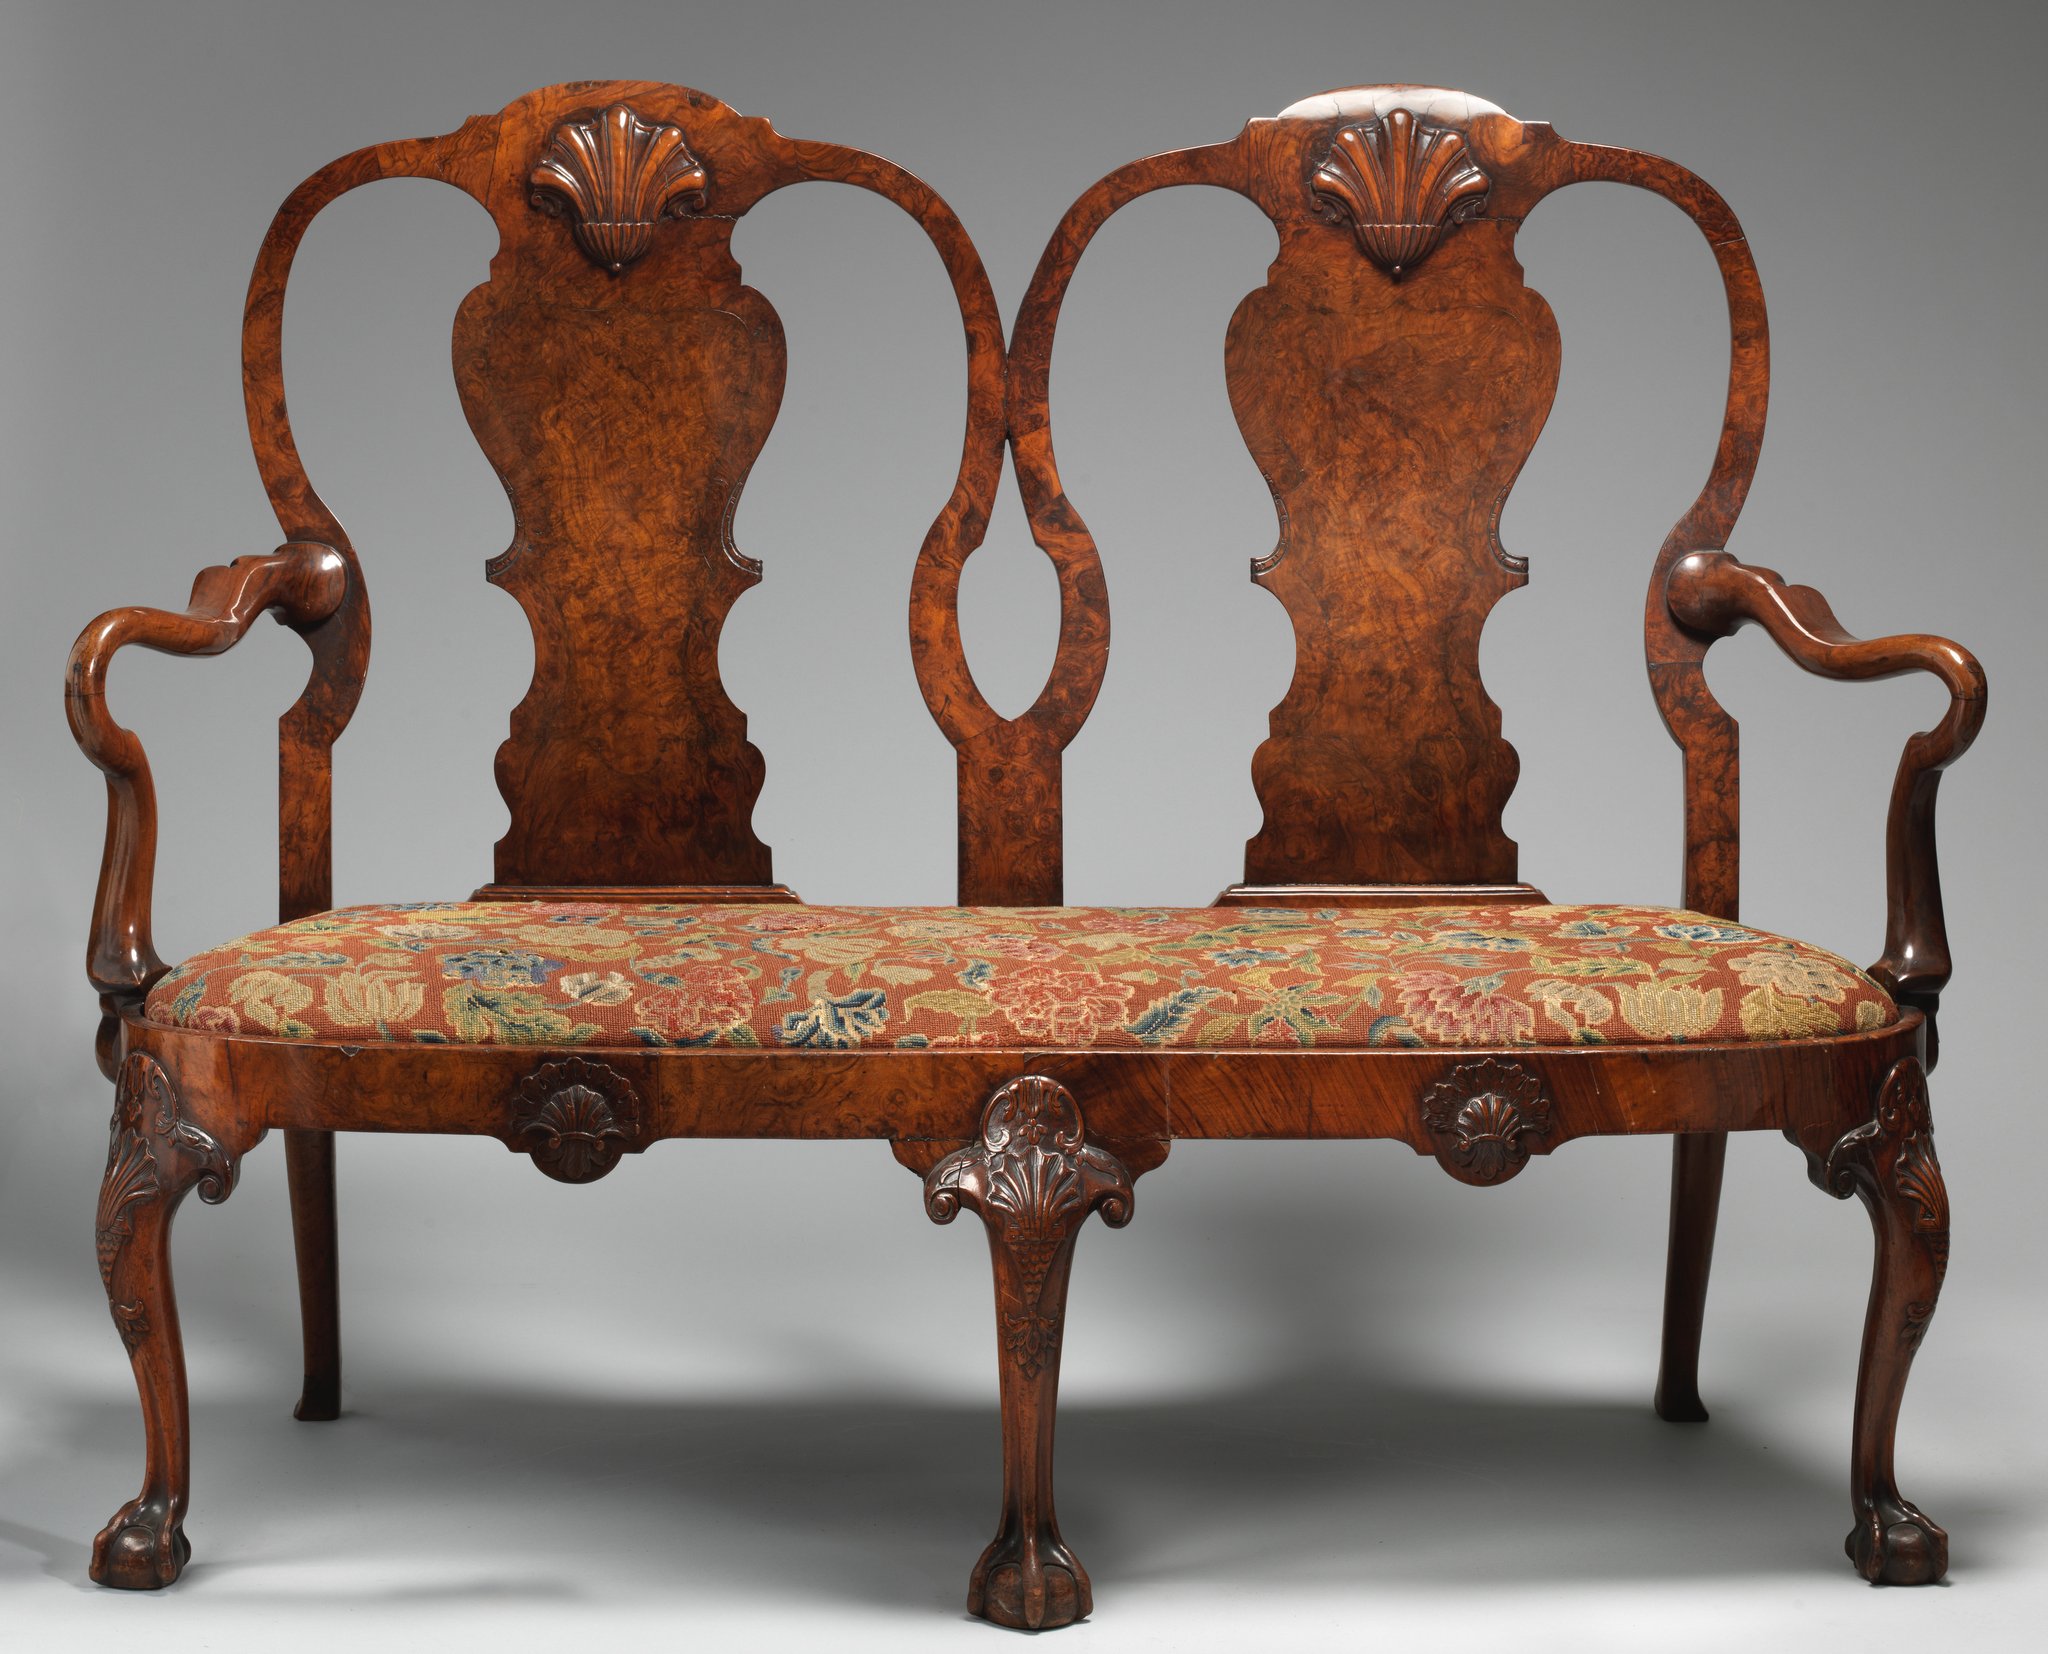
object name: settee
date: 1720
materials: wood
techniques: veneering